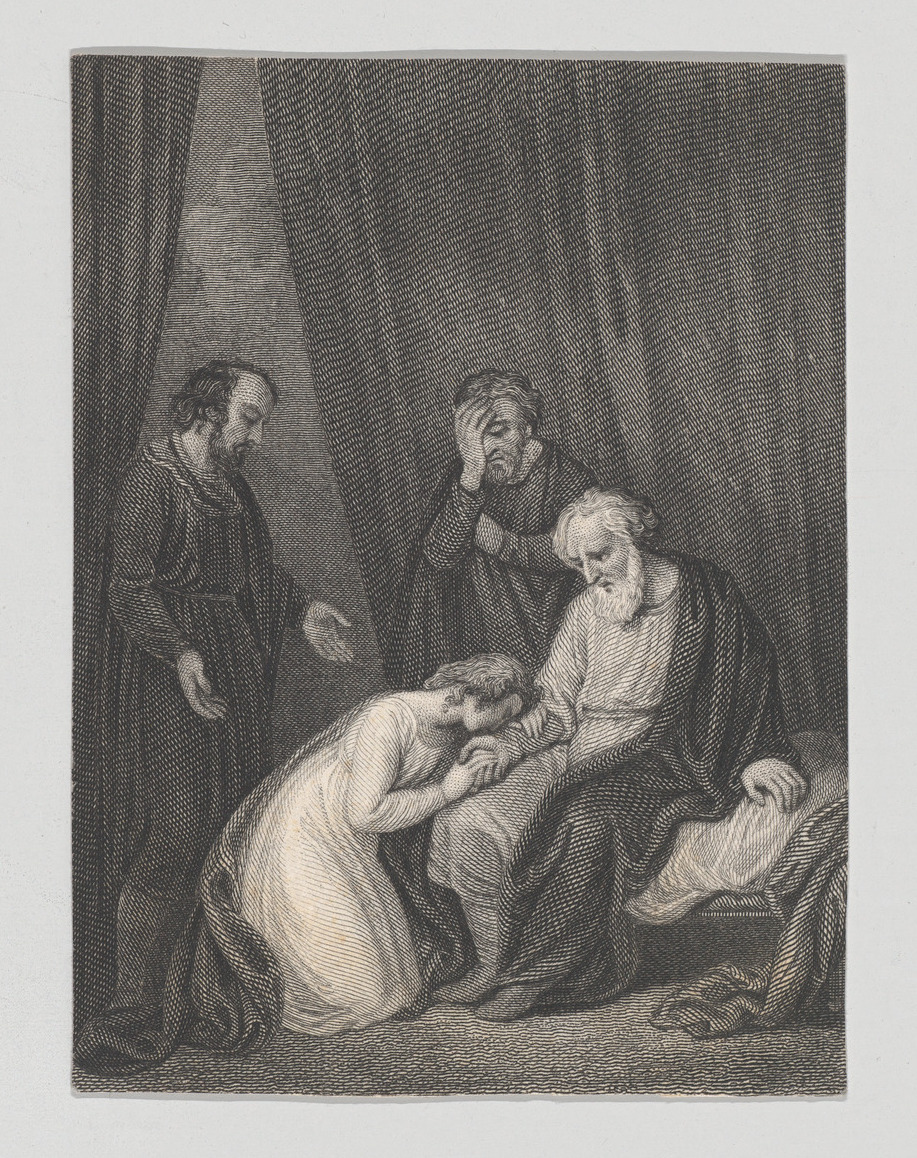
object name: print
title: Cordelia and King Lear (Shakespeare, King Lear, Act 4, Scene 7)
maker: charles heath, the elder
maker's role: engraver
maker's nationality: british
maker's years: 1785-1848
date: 1825-1840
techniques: engraving, etching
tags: kings,shakespeare,sadness,men,women,king lear